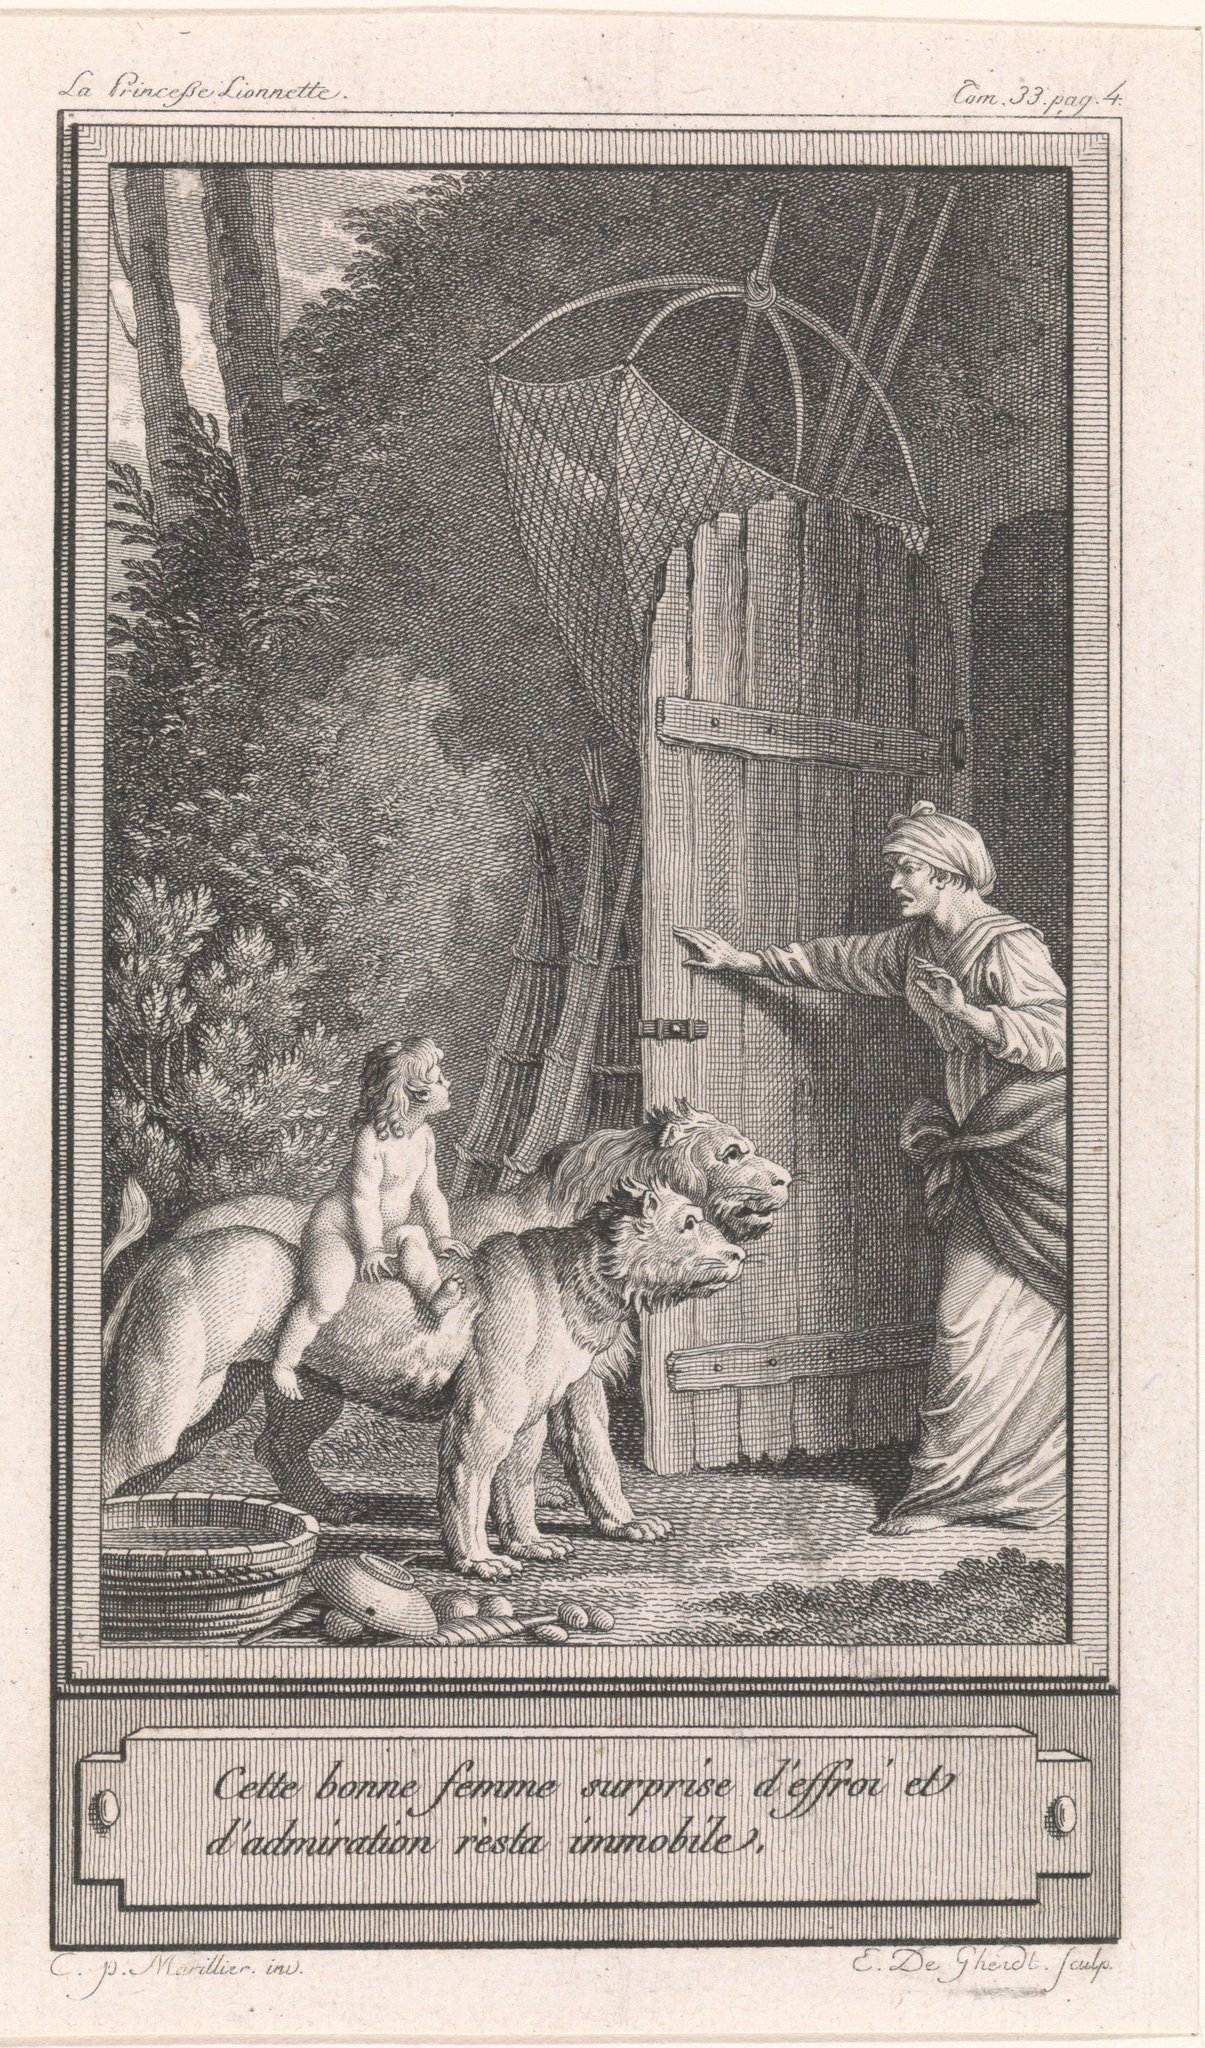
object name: book illustration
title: Prinses Lionnette verschijnt aan haar pleegouders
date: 1748-1815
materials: paper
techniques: engraving, etching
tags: beasts of prey, predatory animals: lion, tales and fairy tales (with title)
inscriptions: collector's mark: Lugt 2228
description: De oude Phila doet de deur van haar huis open en treft buiten twee leeuwen aan. De leeuwin draagt prinses Lionnette op haar rug. De prent heeft een Frans onderschrift in een cartouche.